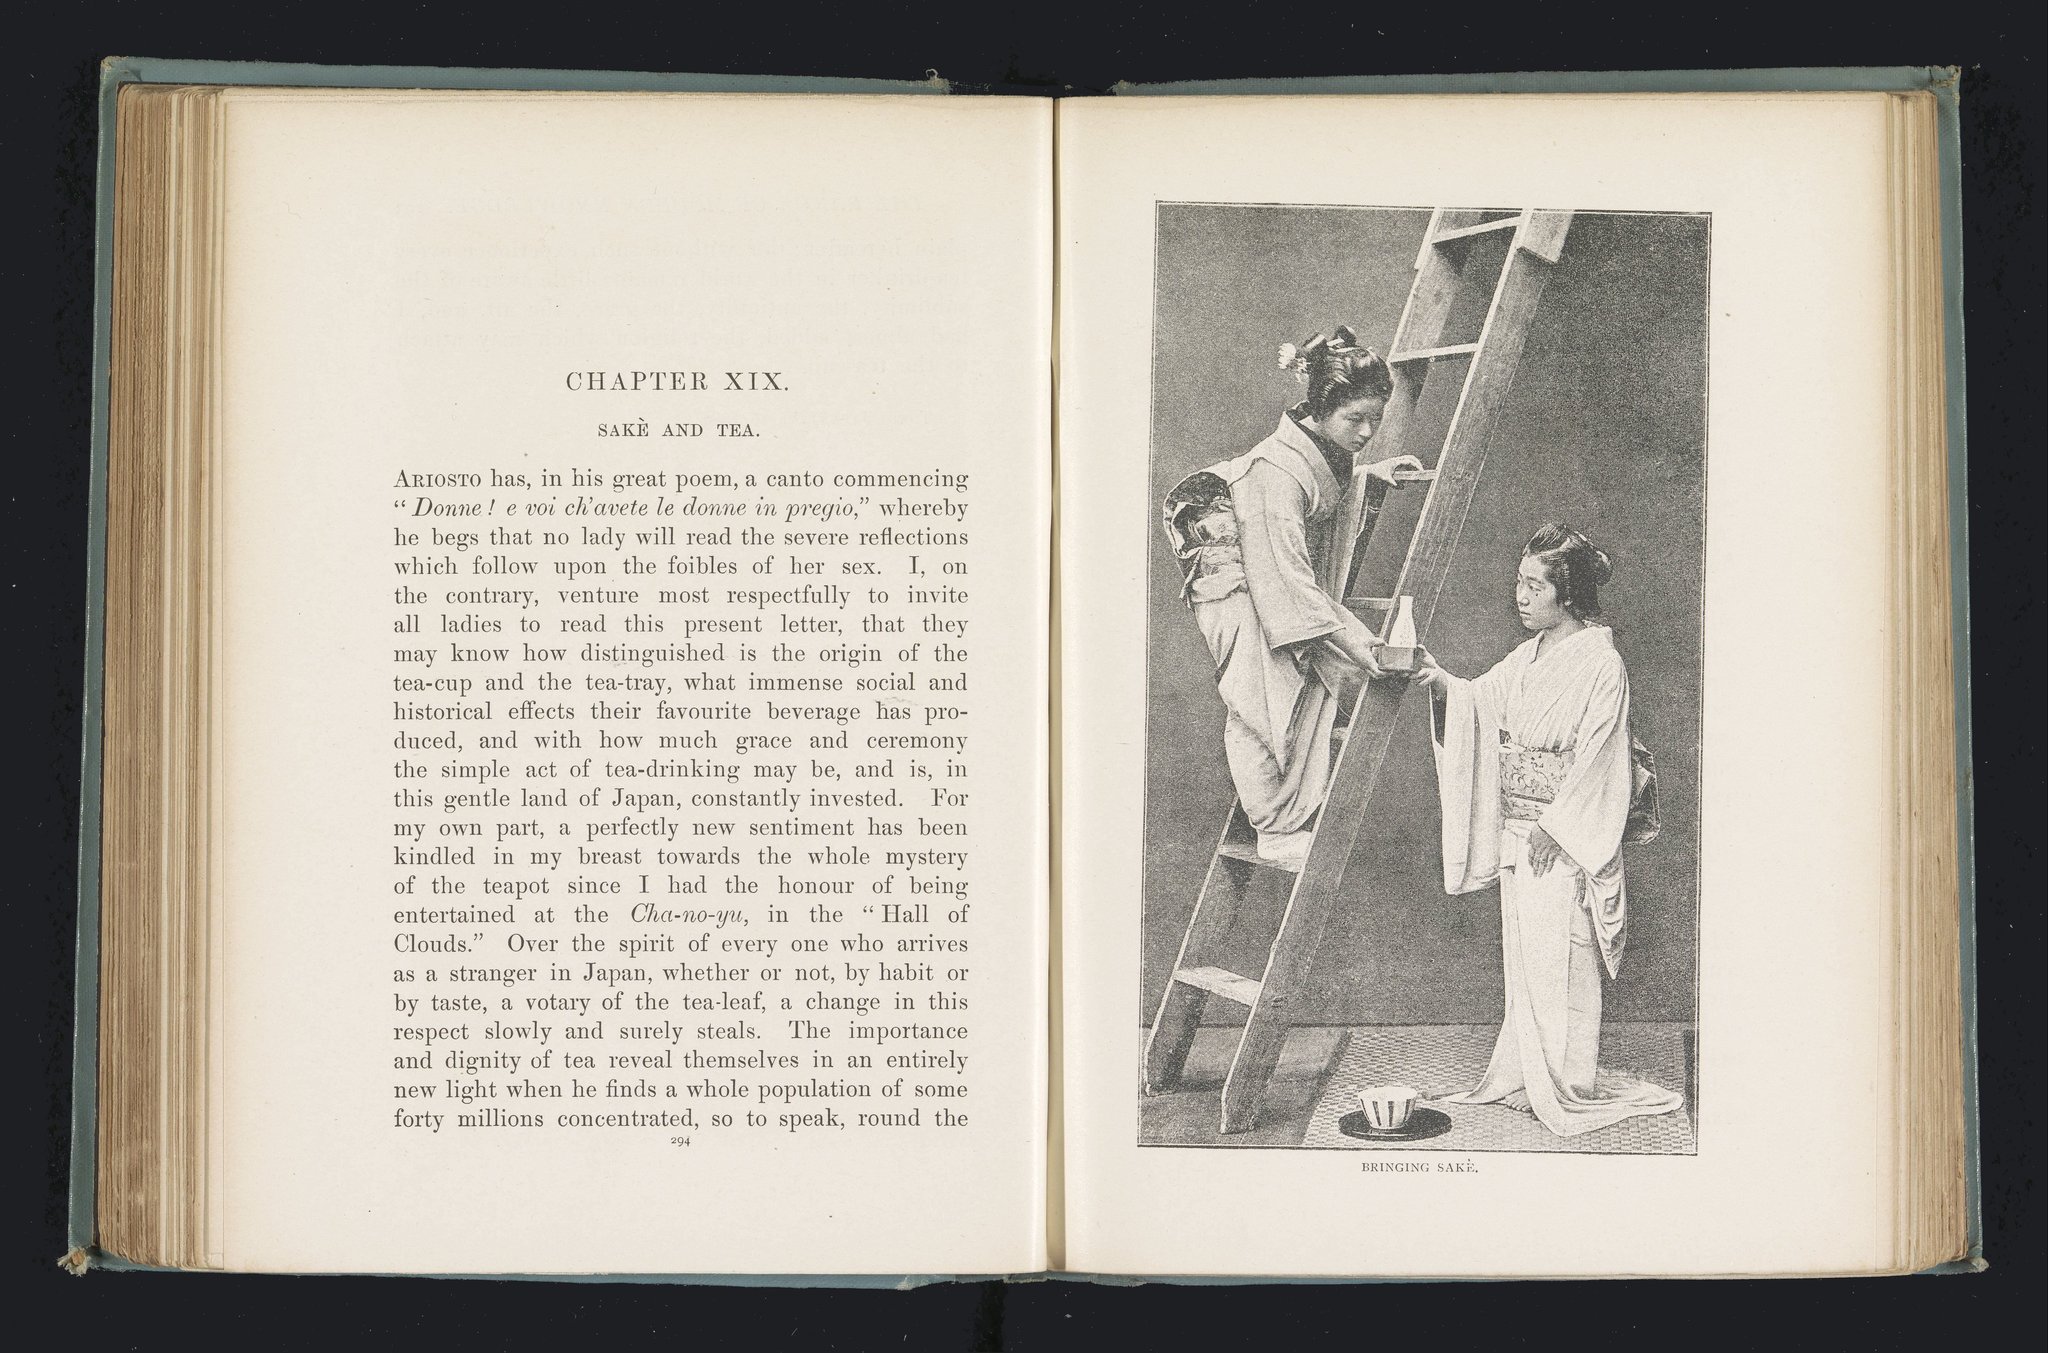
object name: photomechanical print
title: Bringing Sakè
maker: Anonymous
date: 1882-1892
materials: paper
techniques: autotype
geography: japan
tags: studio requisites ~ photographer, alcoholic drinks